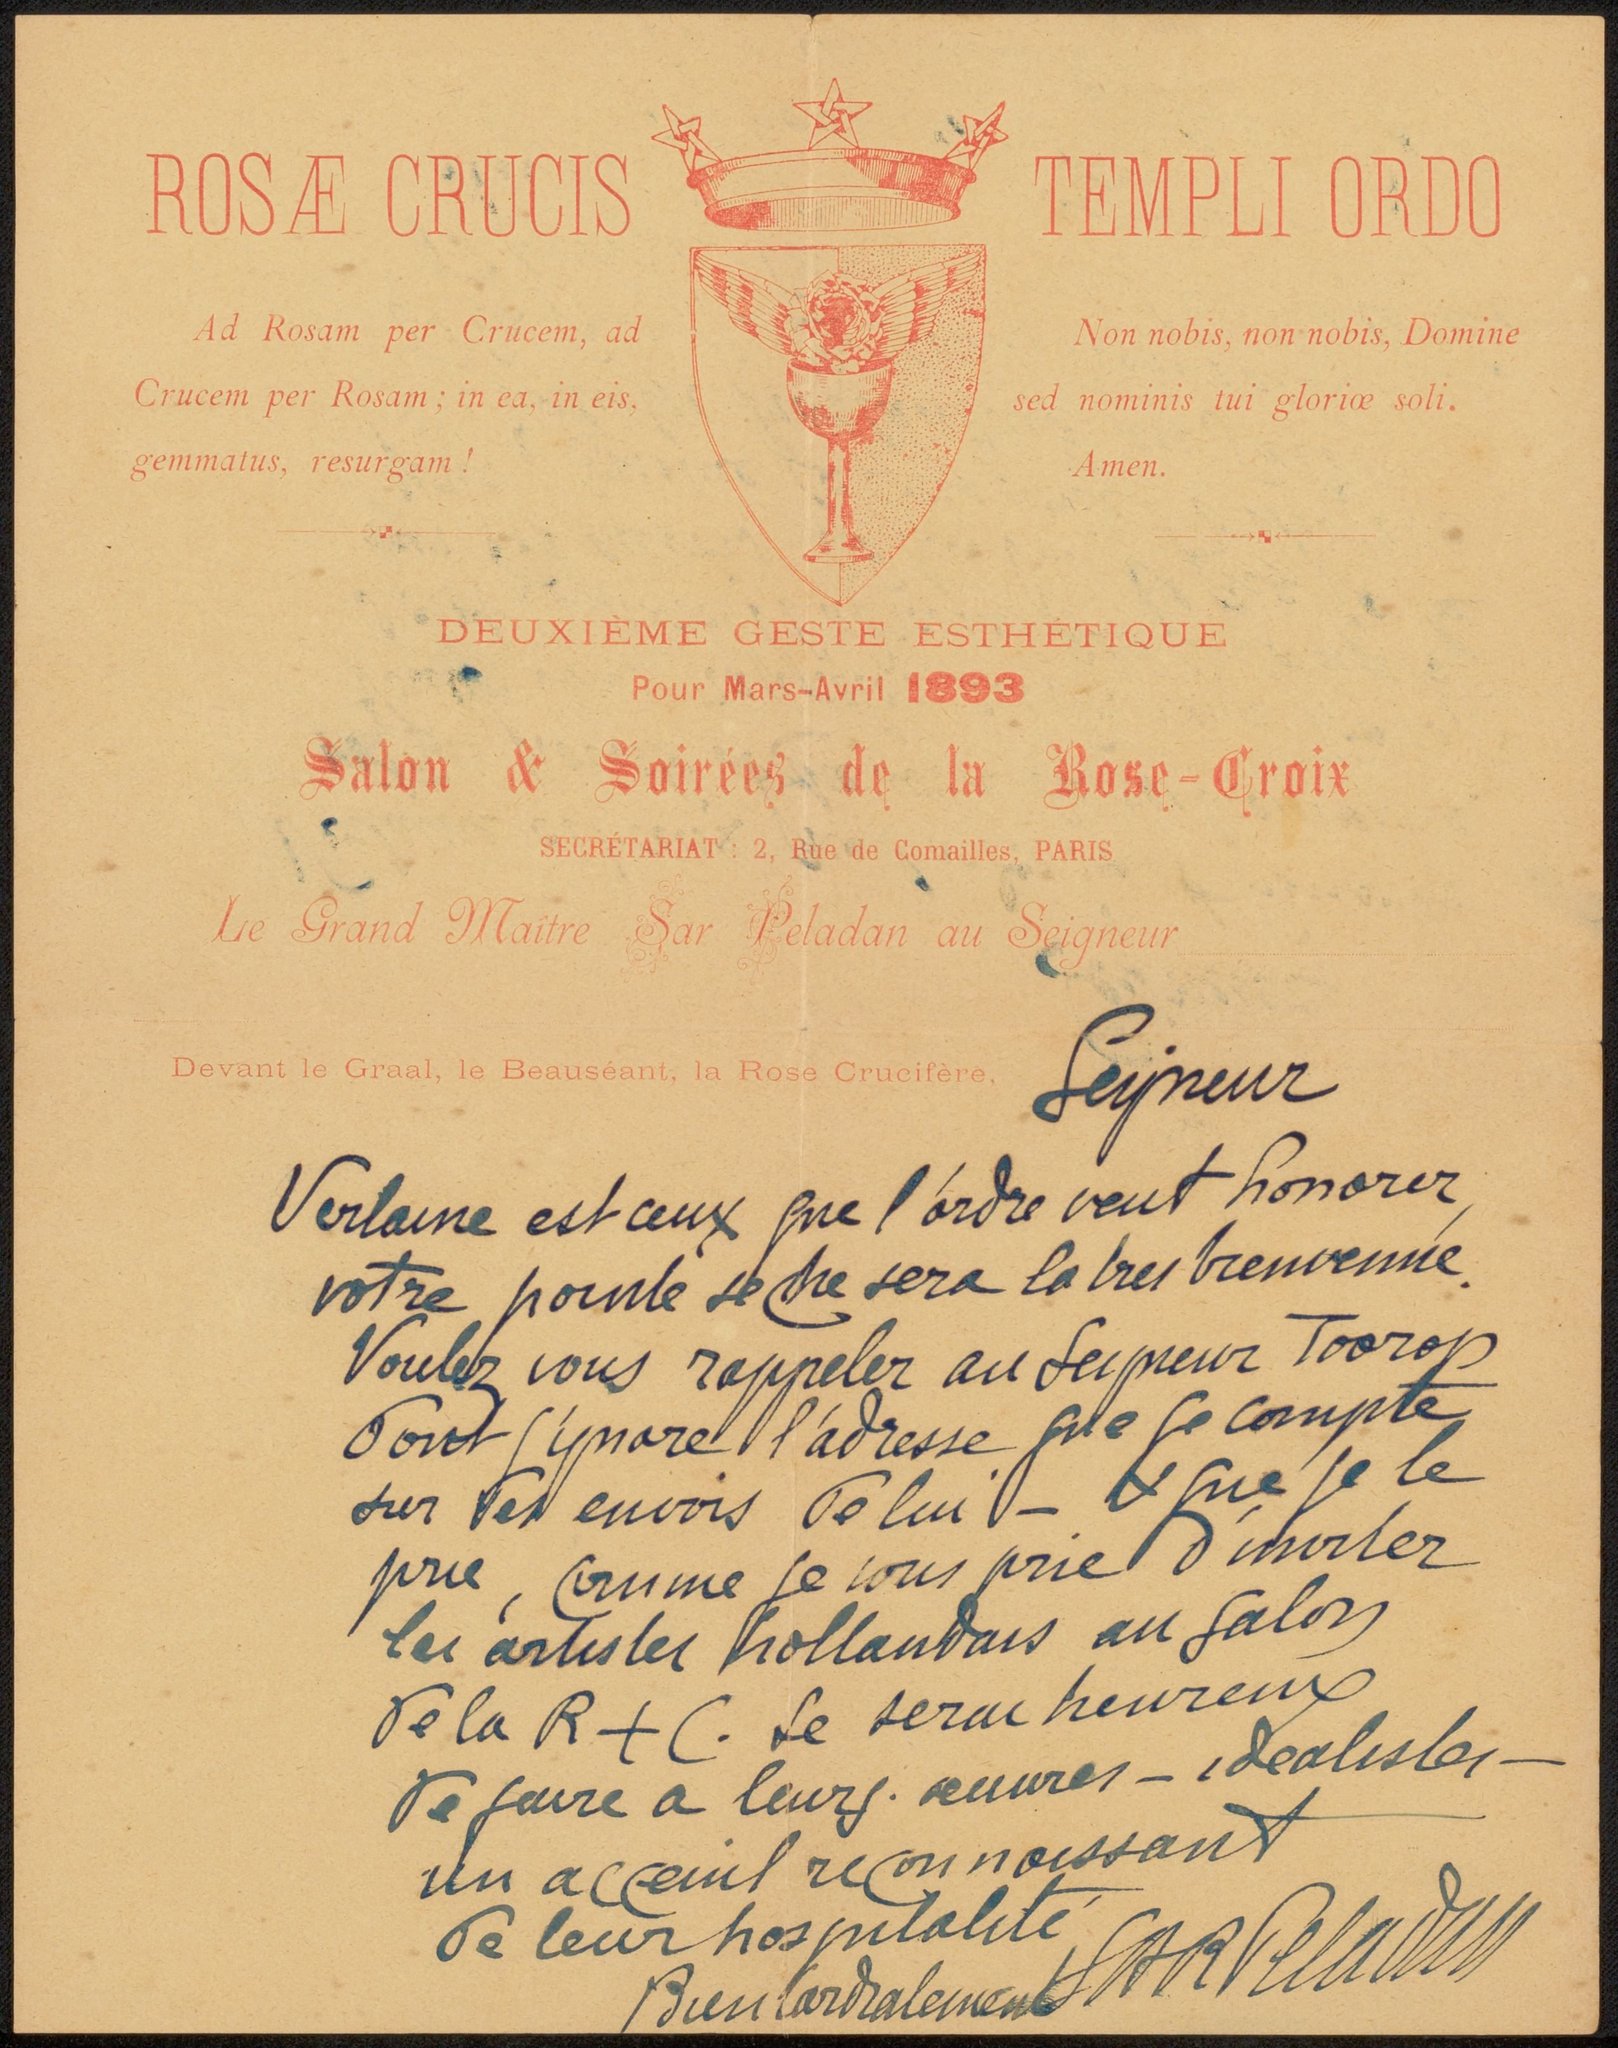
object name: letter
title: Brief aan Philip Zilcken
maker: joséphin péladan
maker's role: schrijver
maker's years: 1858-1918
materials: ink, paper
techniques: pen, printing, writing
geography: nîmes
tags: painter, print maker, draughtsman, jan toorop, paris, paul verlaine, philip zilcken, non-christian religions (including institutions, customs and antiquities)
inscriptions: collector's mark: ‘RPK’